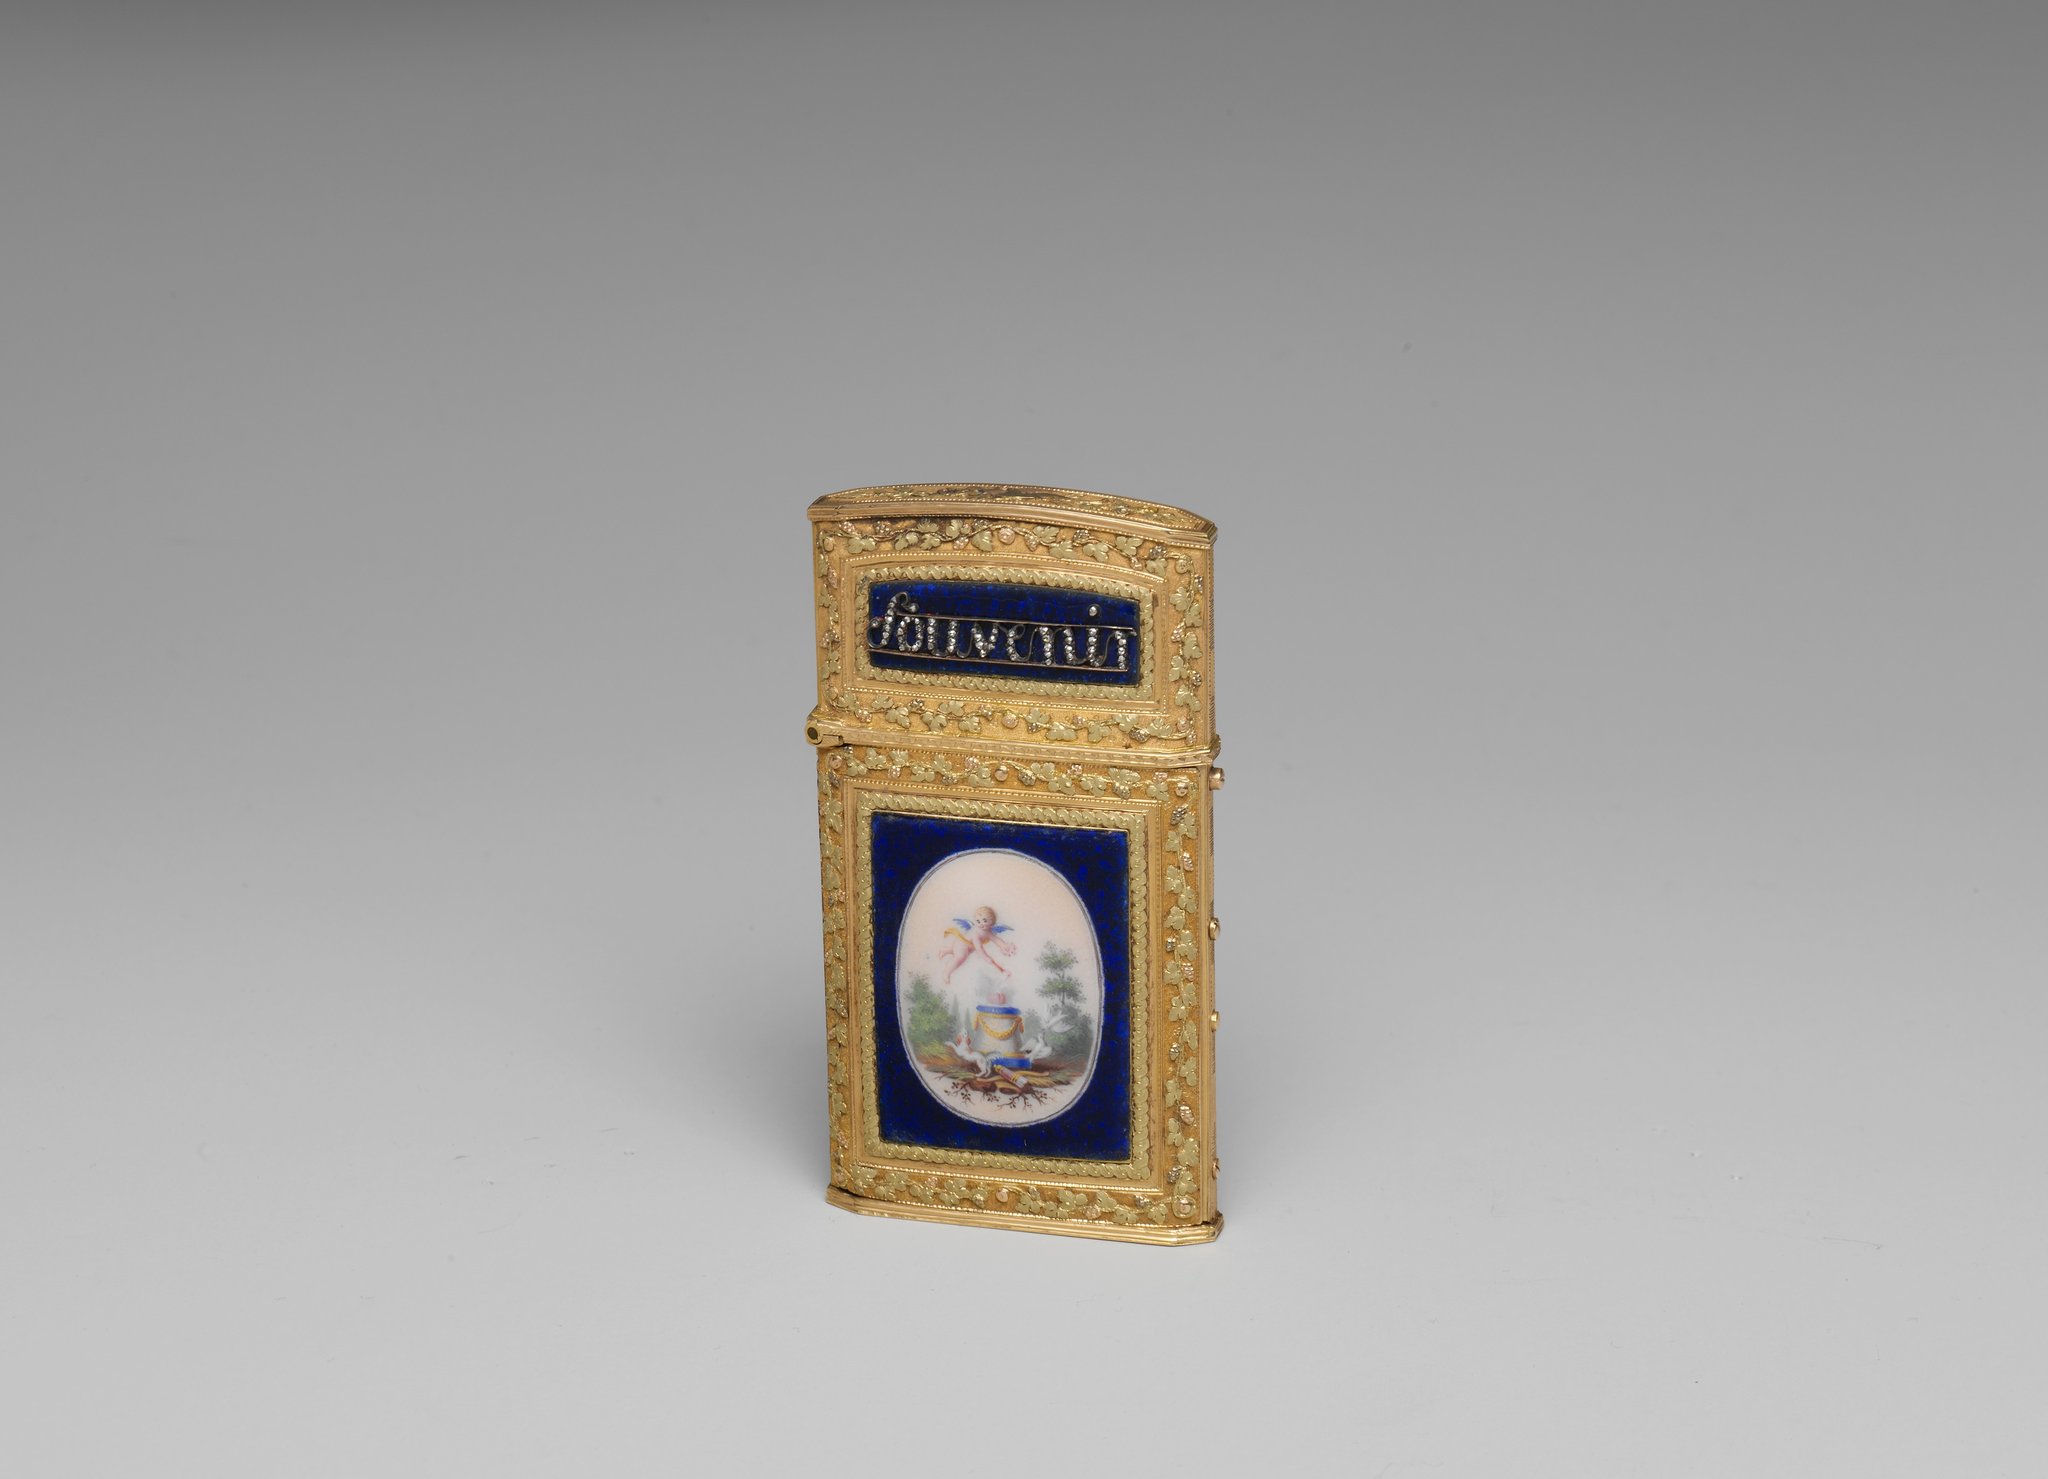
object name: souvenir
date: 1774-1792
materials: diamond, enamel, gold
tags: birds,cupid,dogs,trees,vines